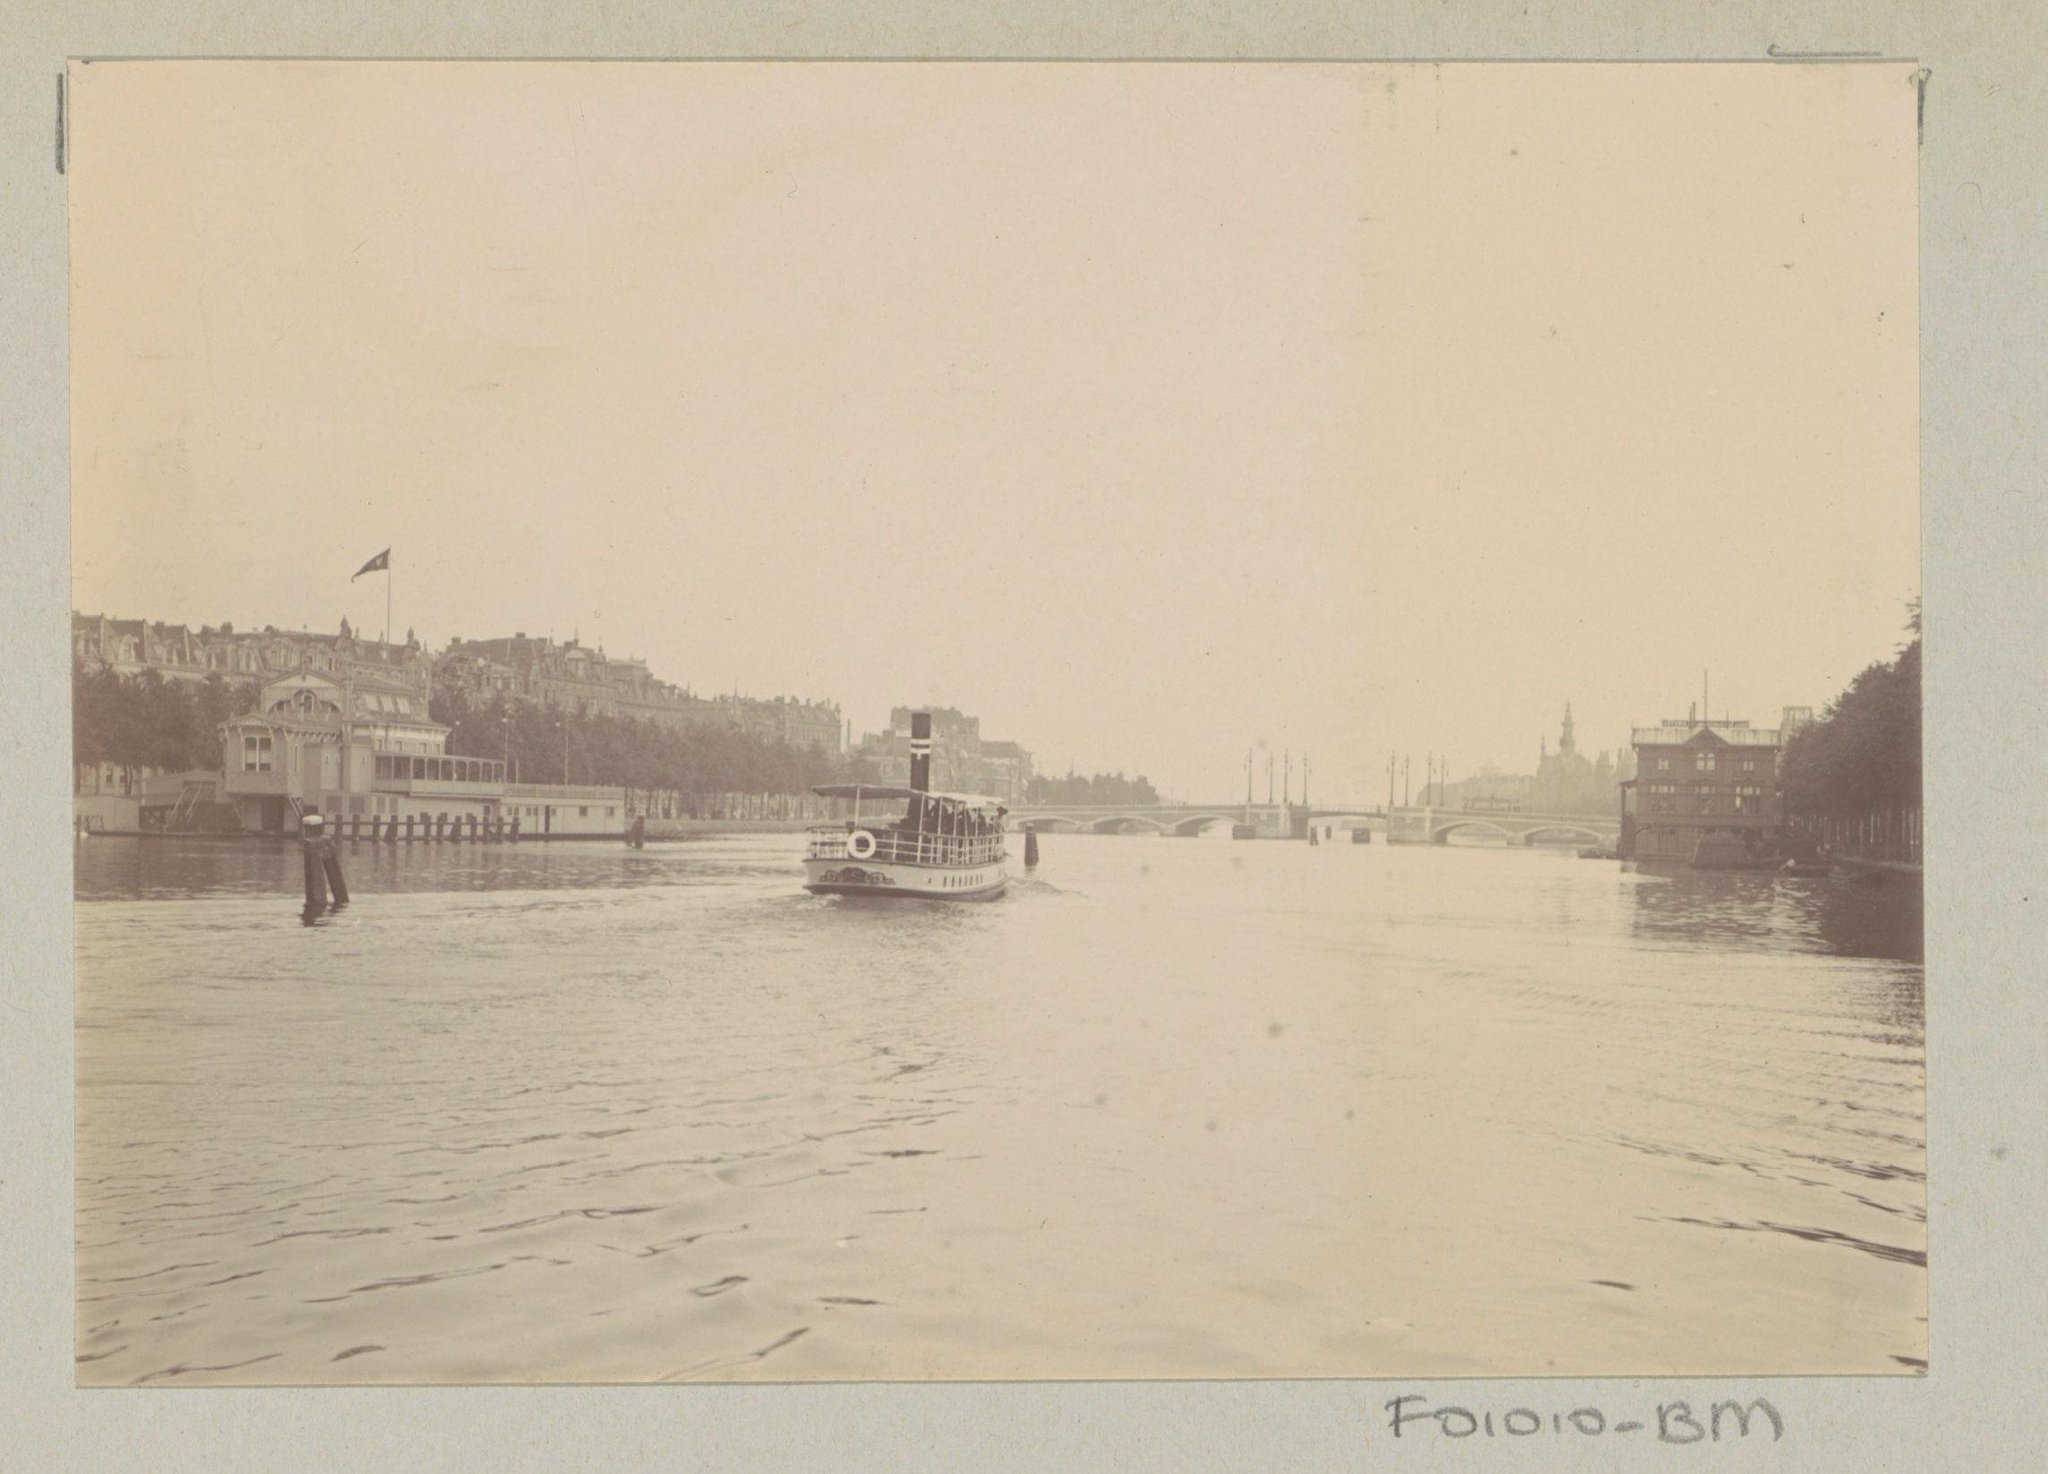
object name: photograph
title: Passagiersboot op de Amstel in Amsterdam, gezien in zuidelijke richting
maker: Anonymous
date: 1900-1910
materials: photographic support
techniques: daylight paper print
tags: passenger liner (+ view ~ vehicle, ship, etc.), river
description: Onderdeel van Familiealbum met onder meer foto's van Wijnhandel Kraaij & Co. Bordeaux-Amsterdam.